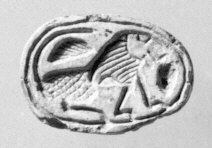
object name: stamp seal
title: Scarab seal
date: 1700-1560 BCE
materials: stone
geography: levant